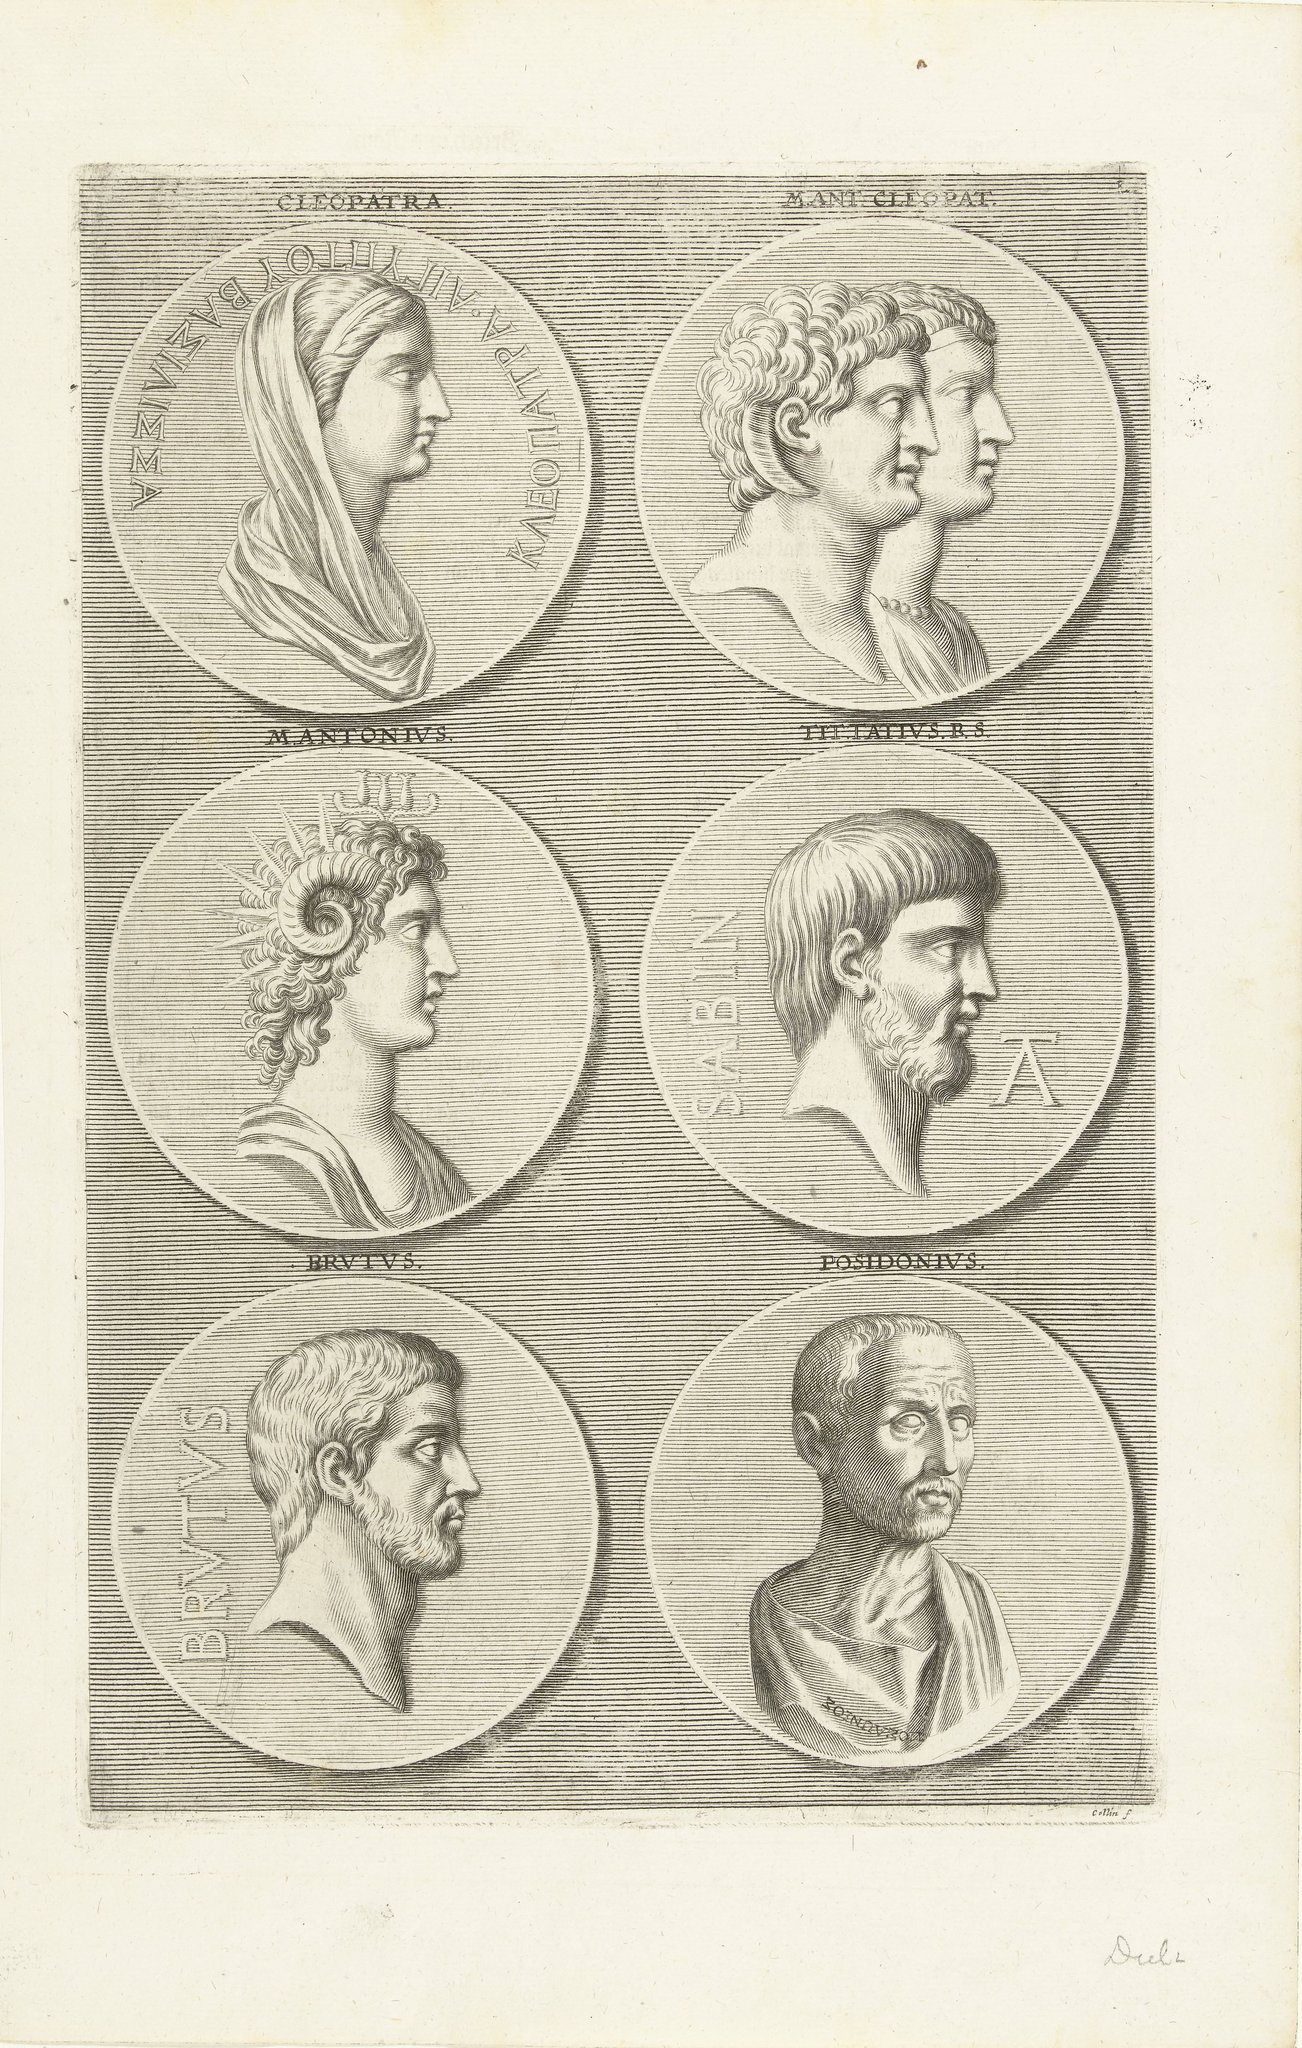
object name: print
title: Zes munten met portretten van mannen en vrouwen uit de klassieke oudheid: letter L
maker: richard collin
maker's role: print maker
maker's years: 1627-1697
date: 1675-1680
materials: paper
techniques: engraving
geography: antwerp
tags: coin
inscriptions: collector's mark: Lugt 2228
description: Illustratie voor: Joachim von Sandrart, L'Academia Todesca della Architectura Scultura e Pittura oder Teutsche Academie der Edlen Bau-, Bild- und Mahlerey-Künste. Nürnberg: 1675-1680.